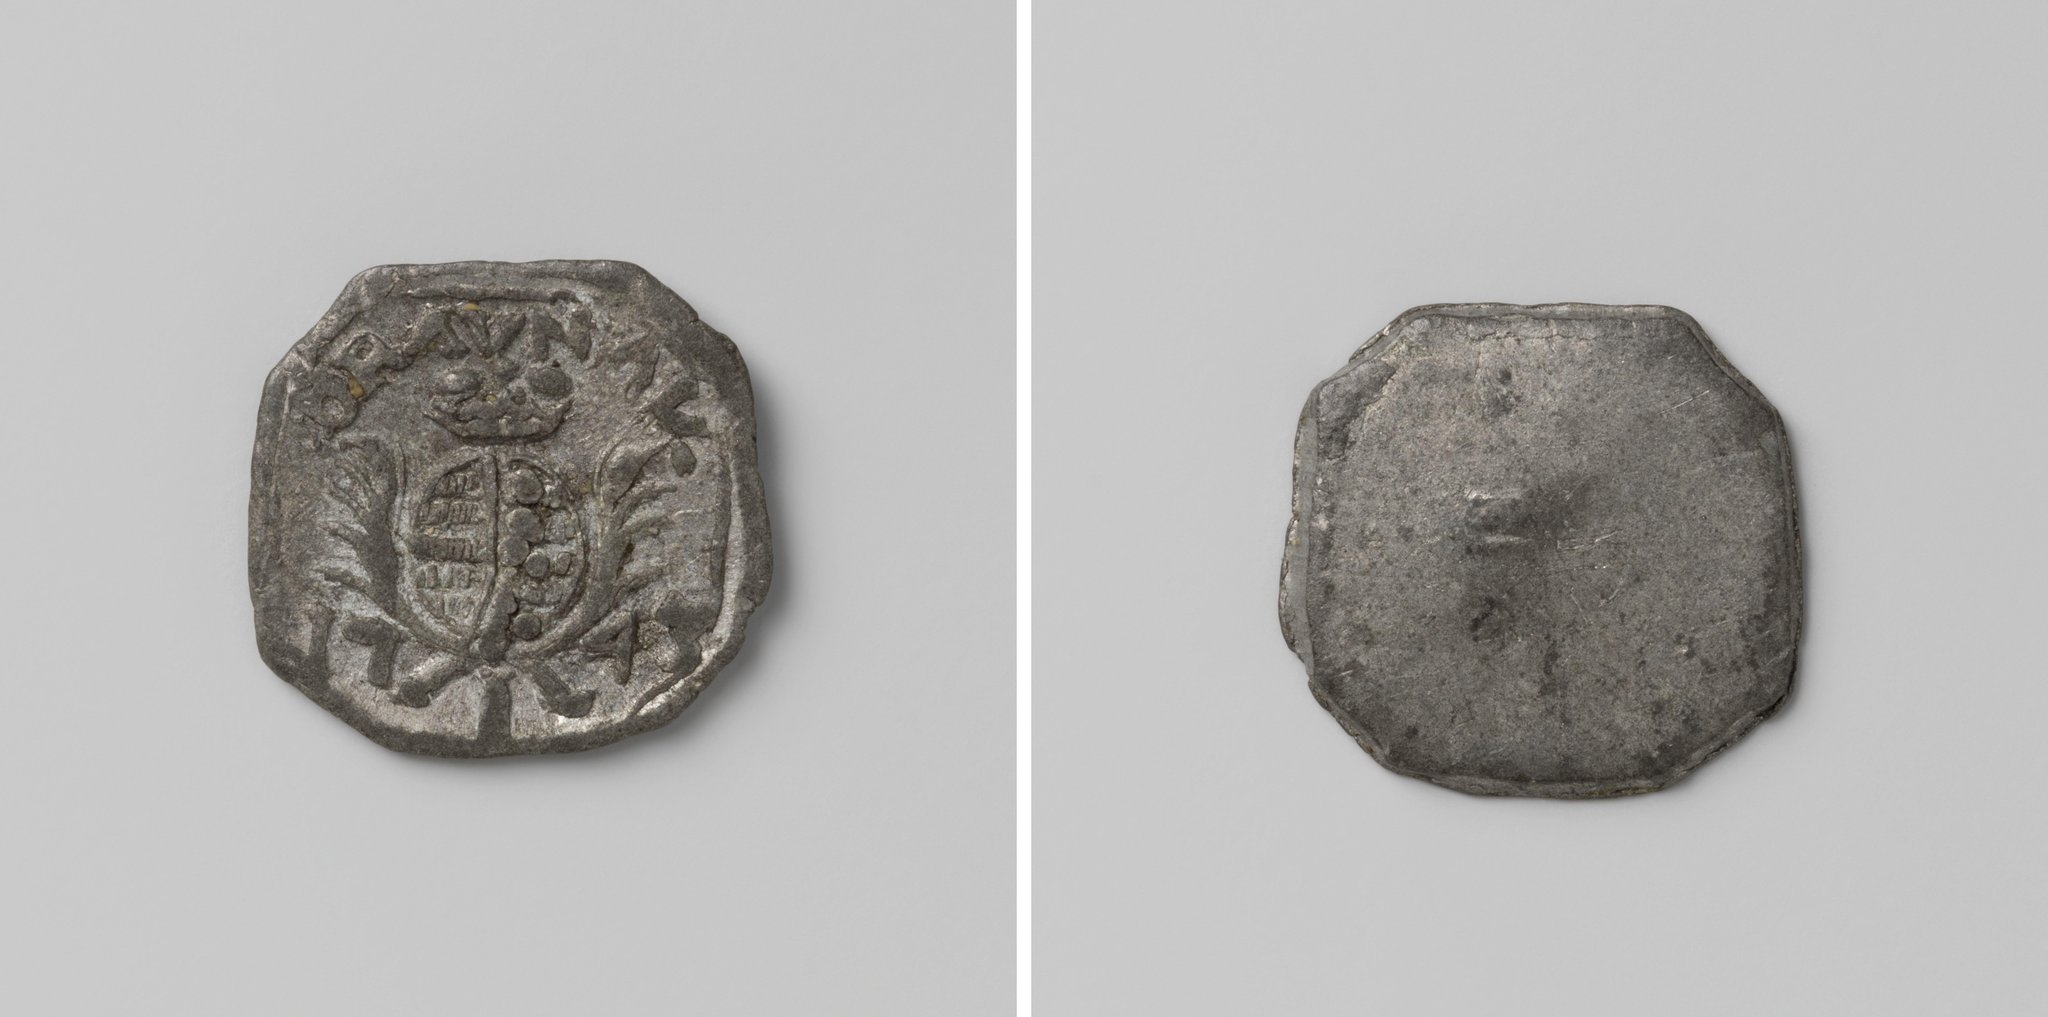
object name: siege coin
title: Kreuzer, noodmunt uit Braunau, geslagen tijdens het beleg door de Oostenrijkers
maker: Anonymous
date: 1743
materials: tin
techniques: striking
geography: braunau-am-inn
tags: braunau-am-inn, beleg van braunau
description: eenzijdige, vierkante noodmunt met afgeschuinde hoeken. Voorzijde: gekroond wapenschild tussen jaartal binnen bladerkrans en omschrift; onder wapenschild: waardeaanduiding. Keerzijde: blanco